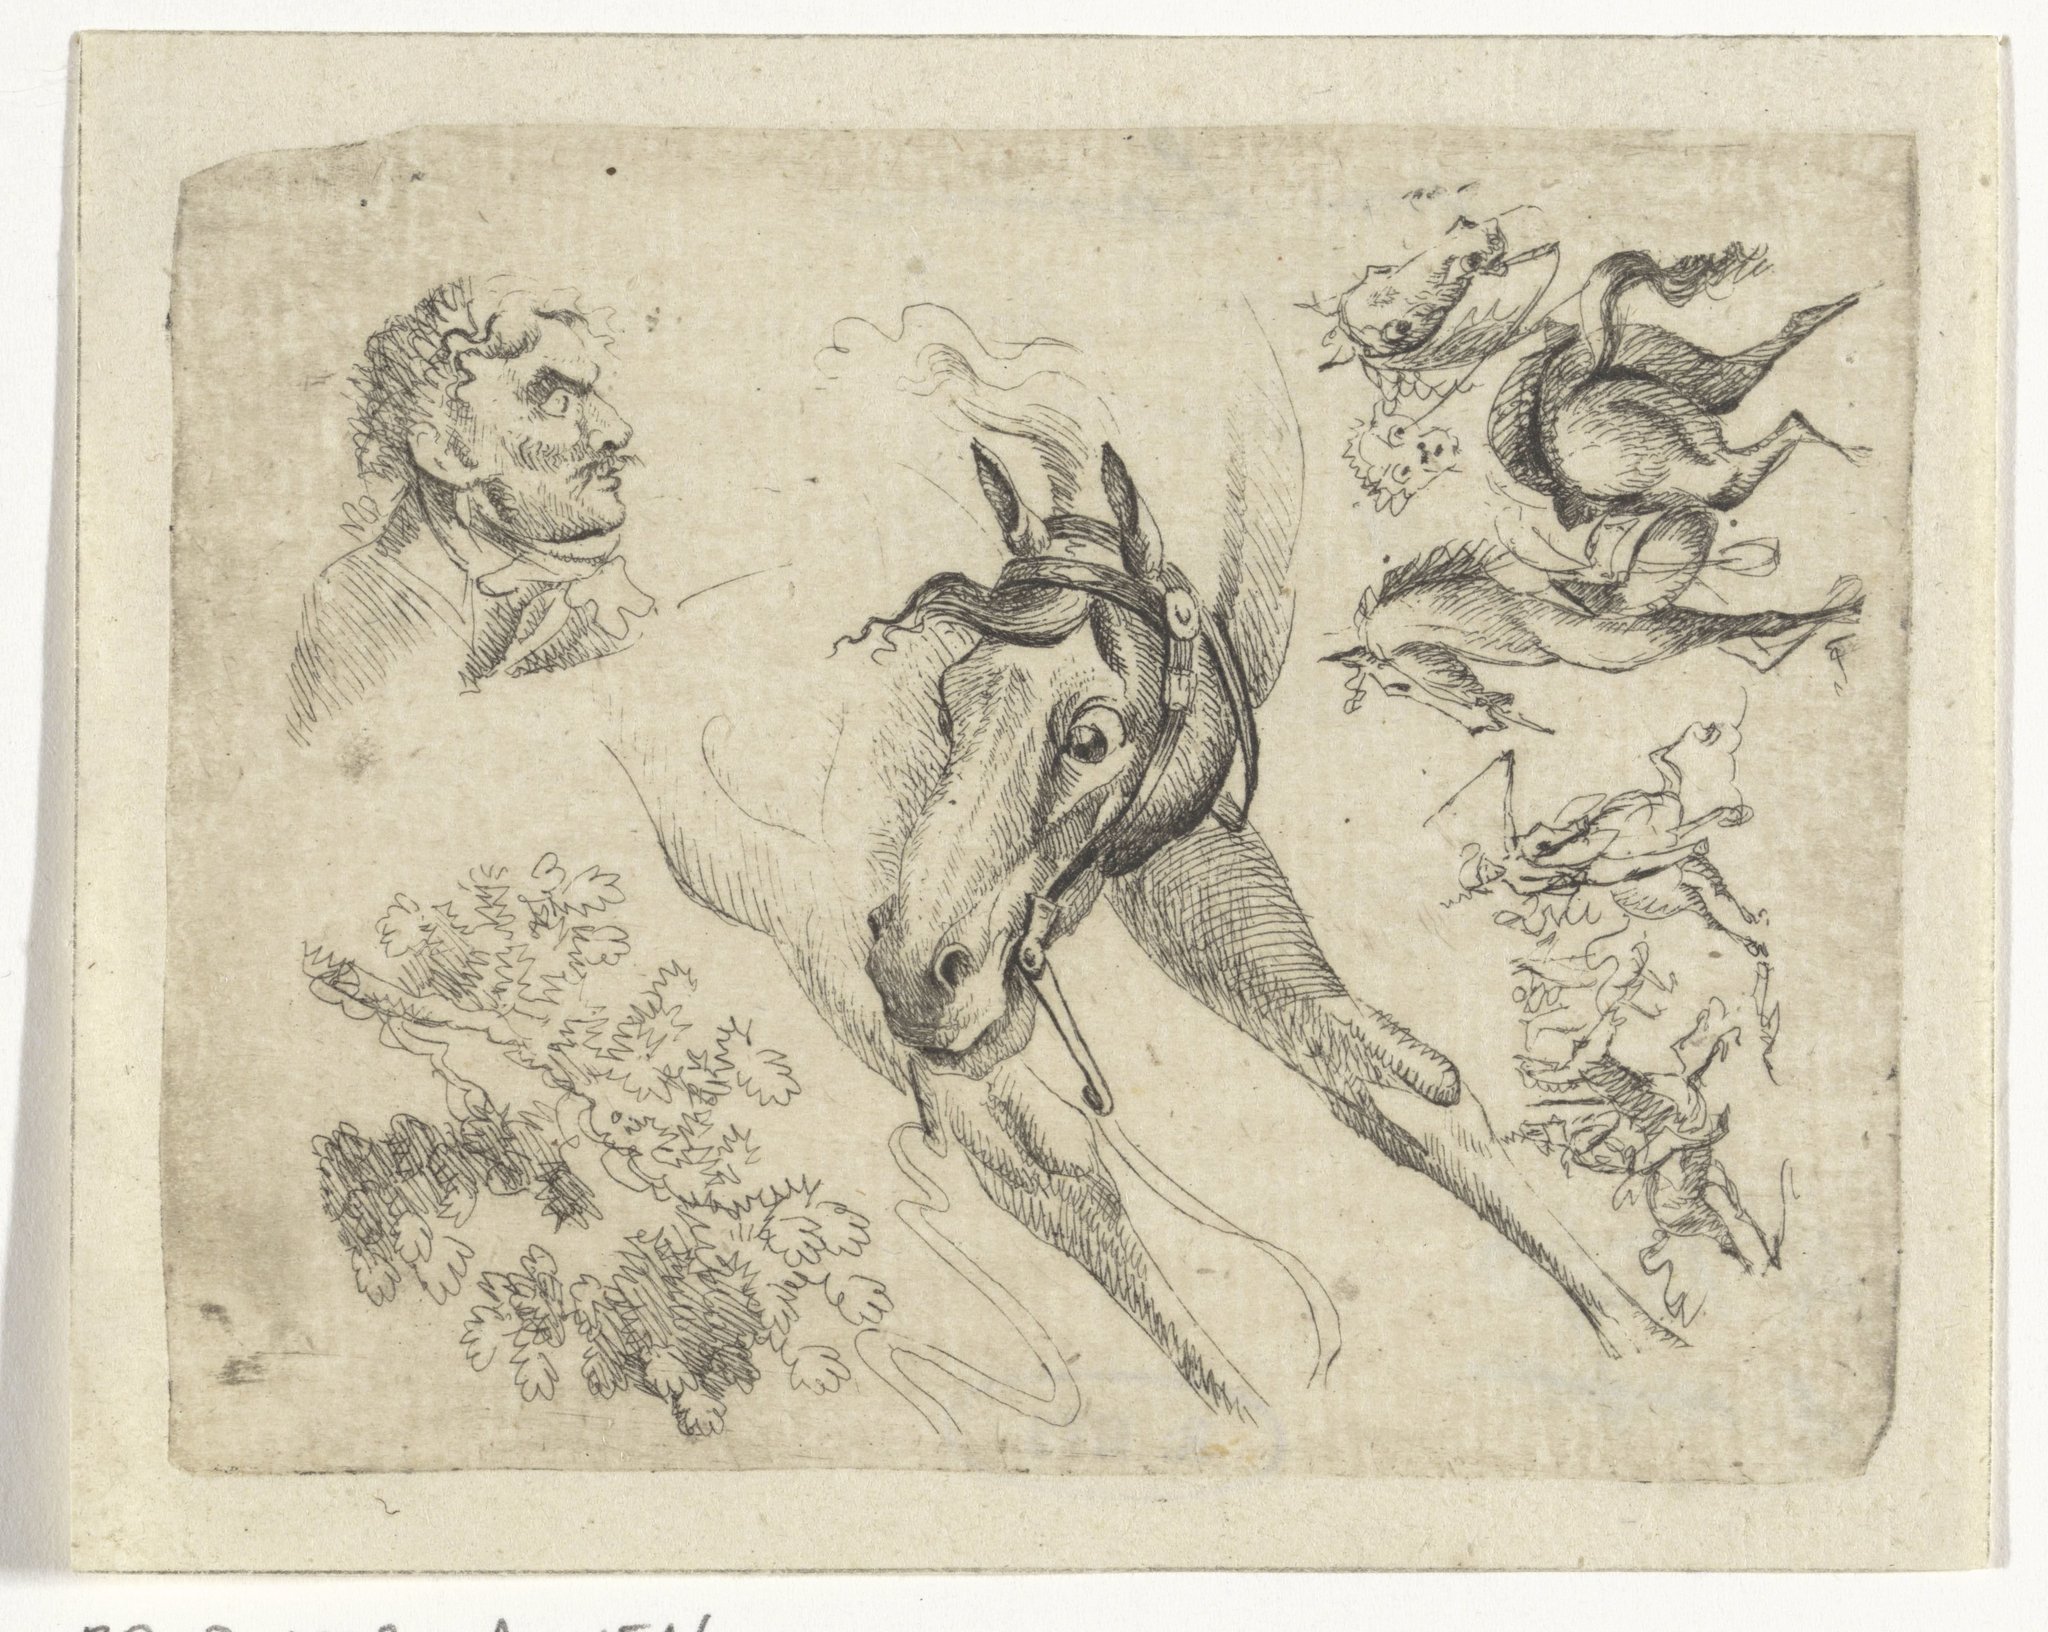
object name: print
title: Studieblad met paarden, een man en een tak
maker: johan bernard scheffer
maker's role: draughtsman, painter, print maker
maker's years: 1765-1809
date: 1788-1809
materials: paper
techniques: etching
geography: northern netherlands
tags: riding a horse, ass, or mule; rider, horseman, trees (+ branch, stick), adult man, horse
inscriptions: collector's mark: Lugt 2228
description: Studieblad met linksboven een man en profil. In het midden een galopperend paard. Rechtsboven enkele paarden. Linksonder een boomtak en rechtsonder enkele ruiters te paard.